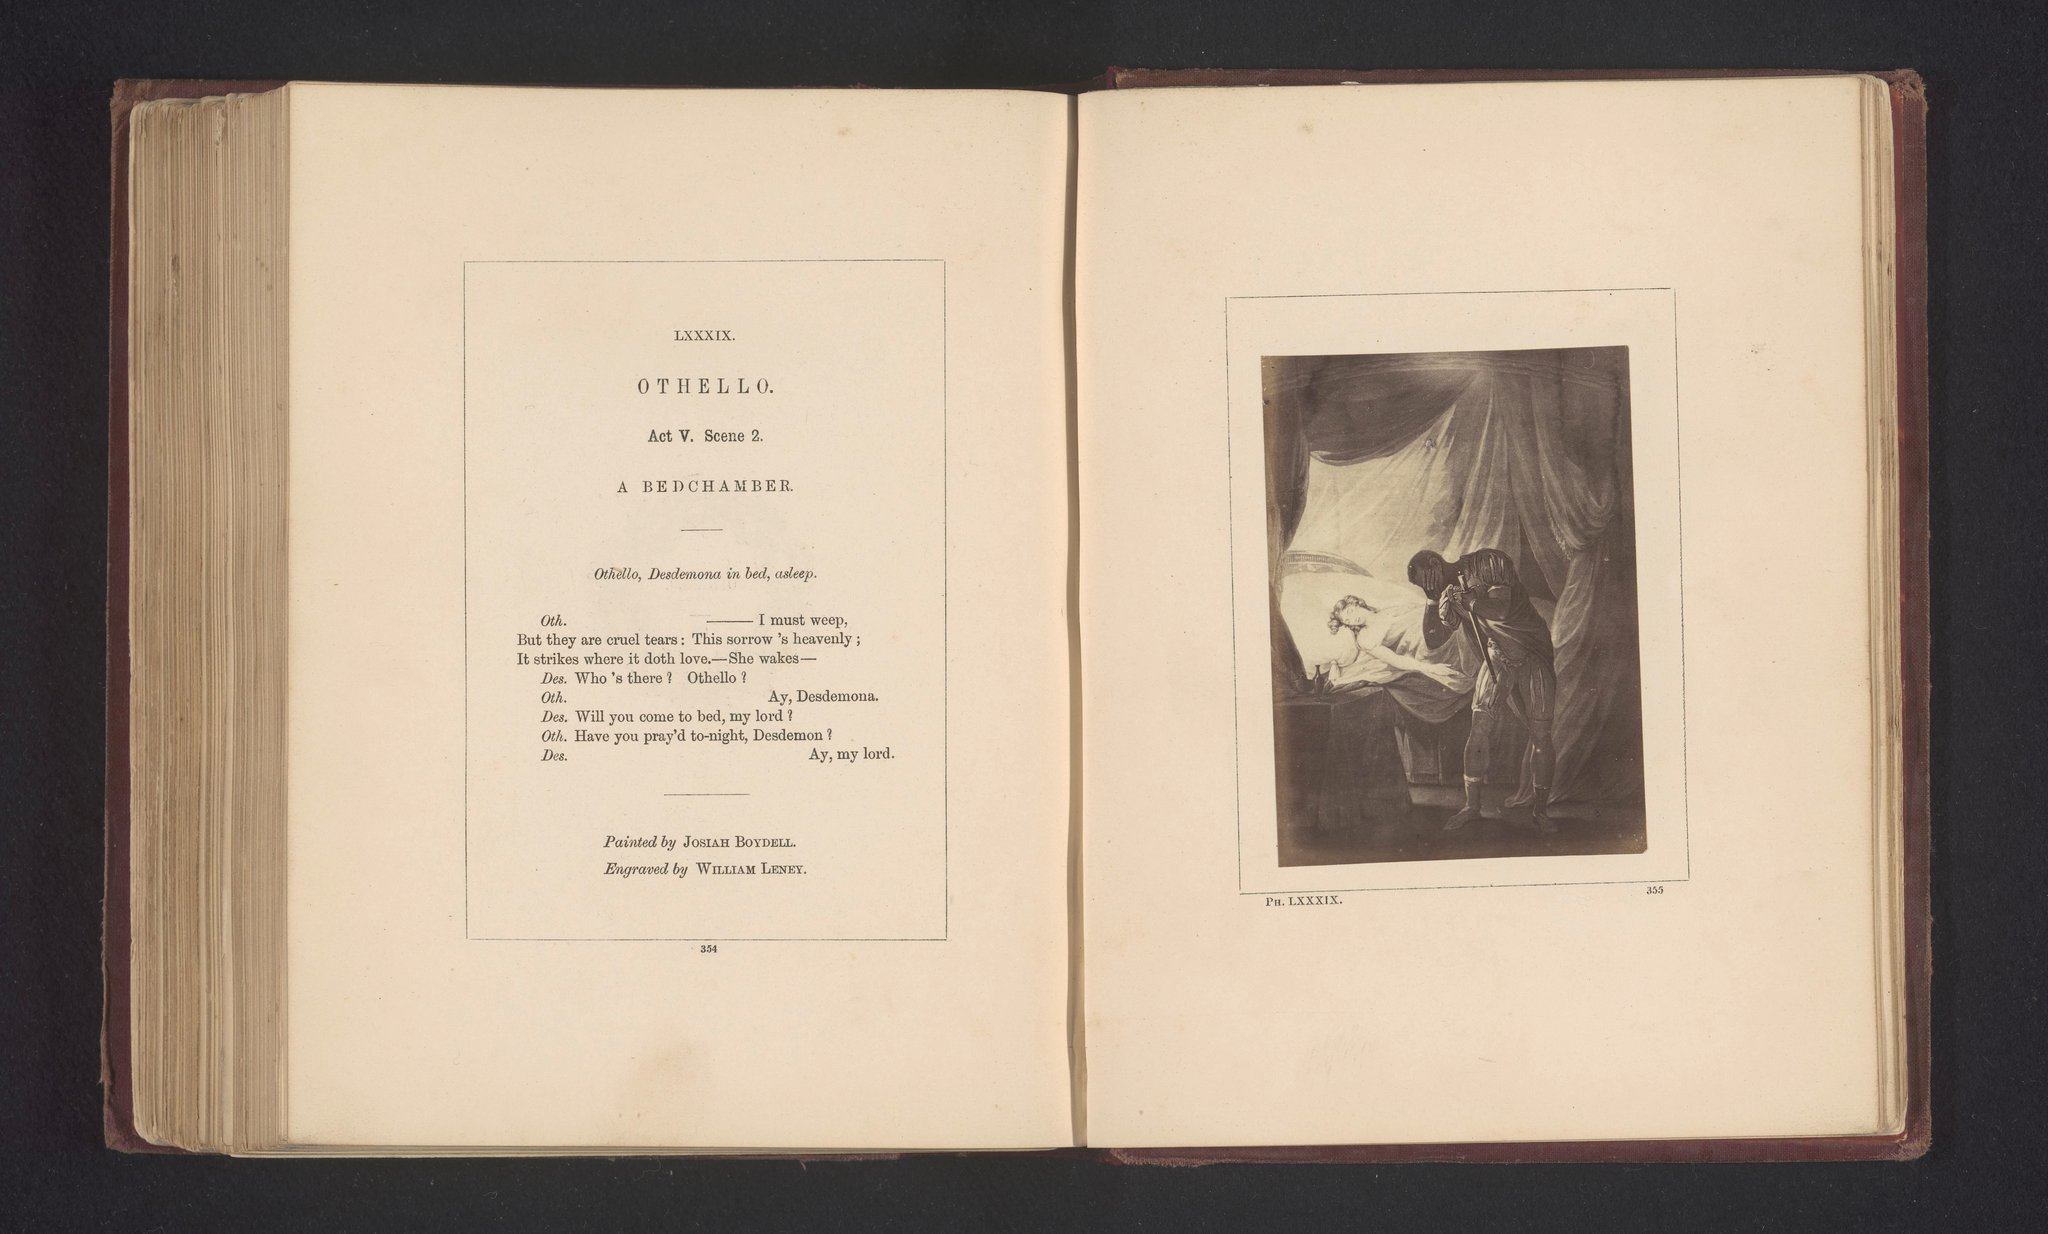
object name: reproduction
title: Fotoreproductie van een prent naar een schilderij door Josiah Boydell, voorstellend een scene uit Othello door William Shakespeare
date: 1854-1867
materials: photographic support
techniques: albumen print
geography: london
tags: specific works of literature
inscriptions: number: ‘Ph. LXXXIX. 355’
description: Te zien is akte V, scene 2 met Desdemona in bed en Othello die vermoedelijk zichzelf steekt met zijn zwaard.